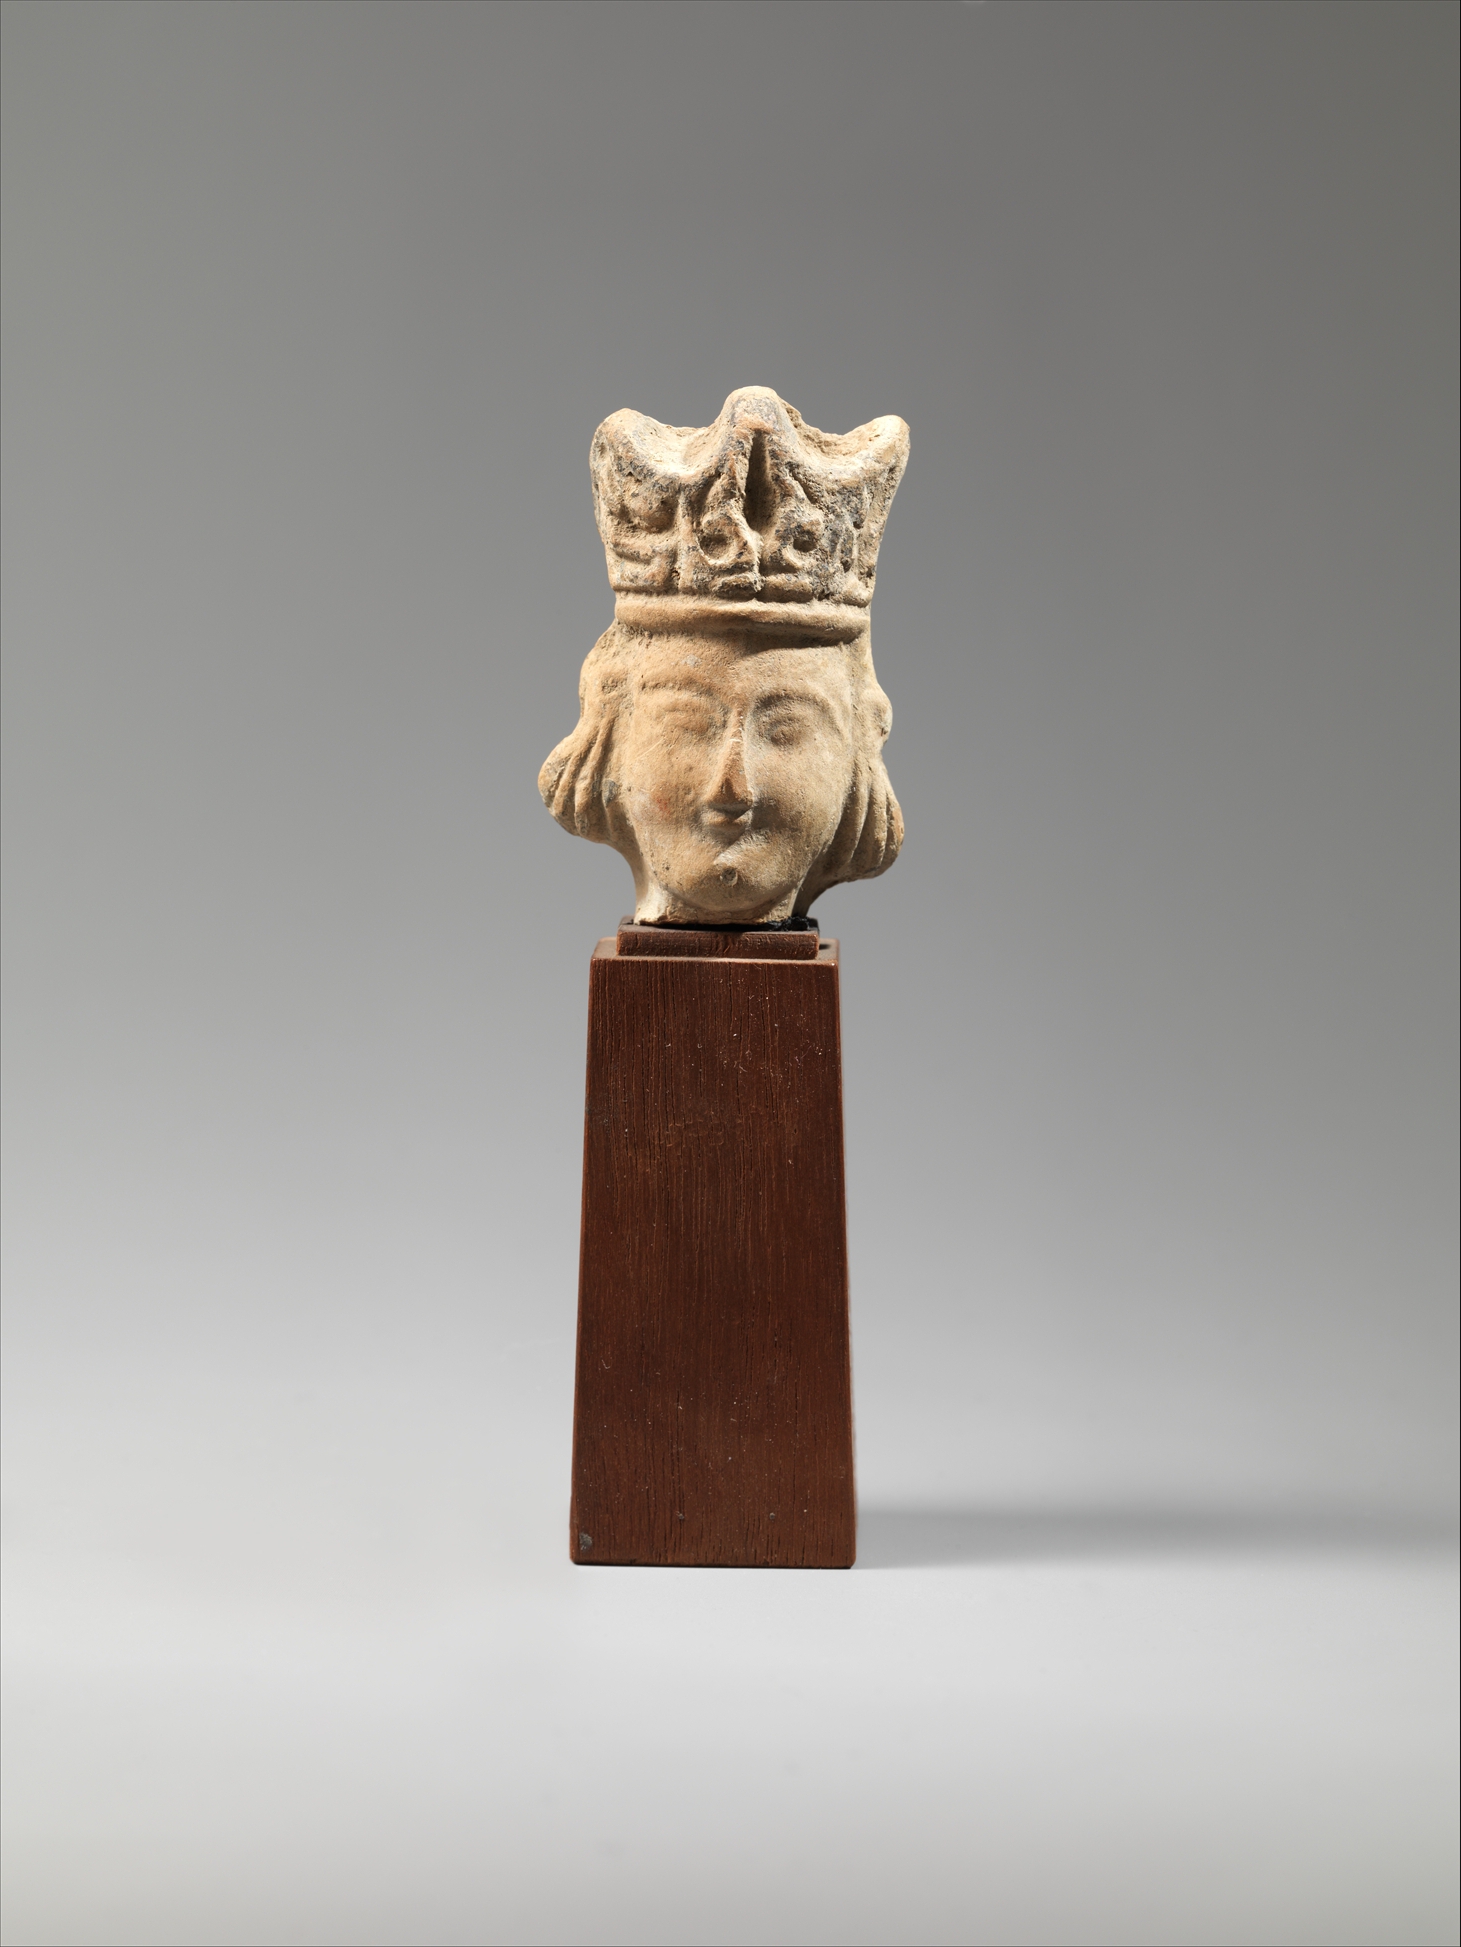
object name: head of a figure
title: Head of a Figurine with an Elaborate Headdress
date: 1101-1300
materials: earthenware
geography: iran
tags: heads,men